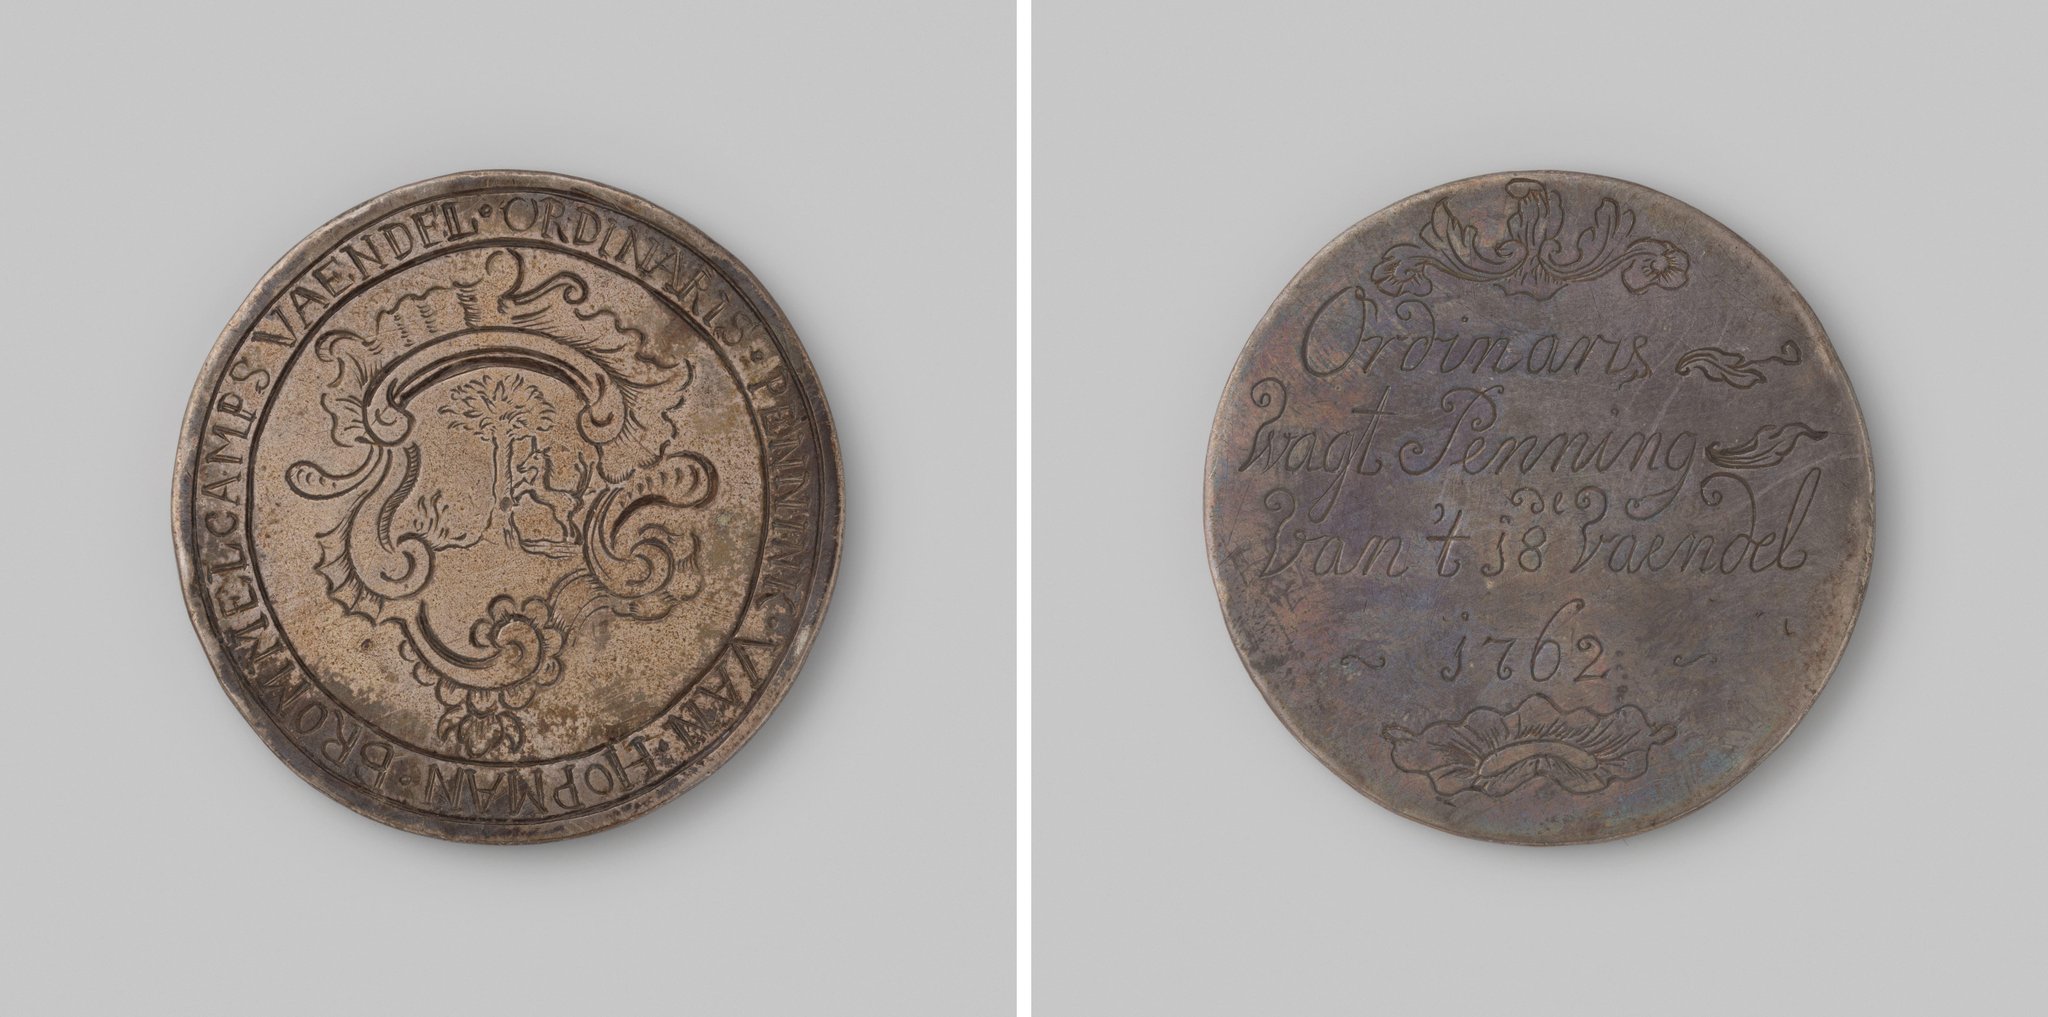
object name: history medal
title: Wachtpenning van het 18e vaandel van?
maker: Anonymous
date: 1762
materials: silver